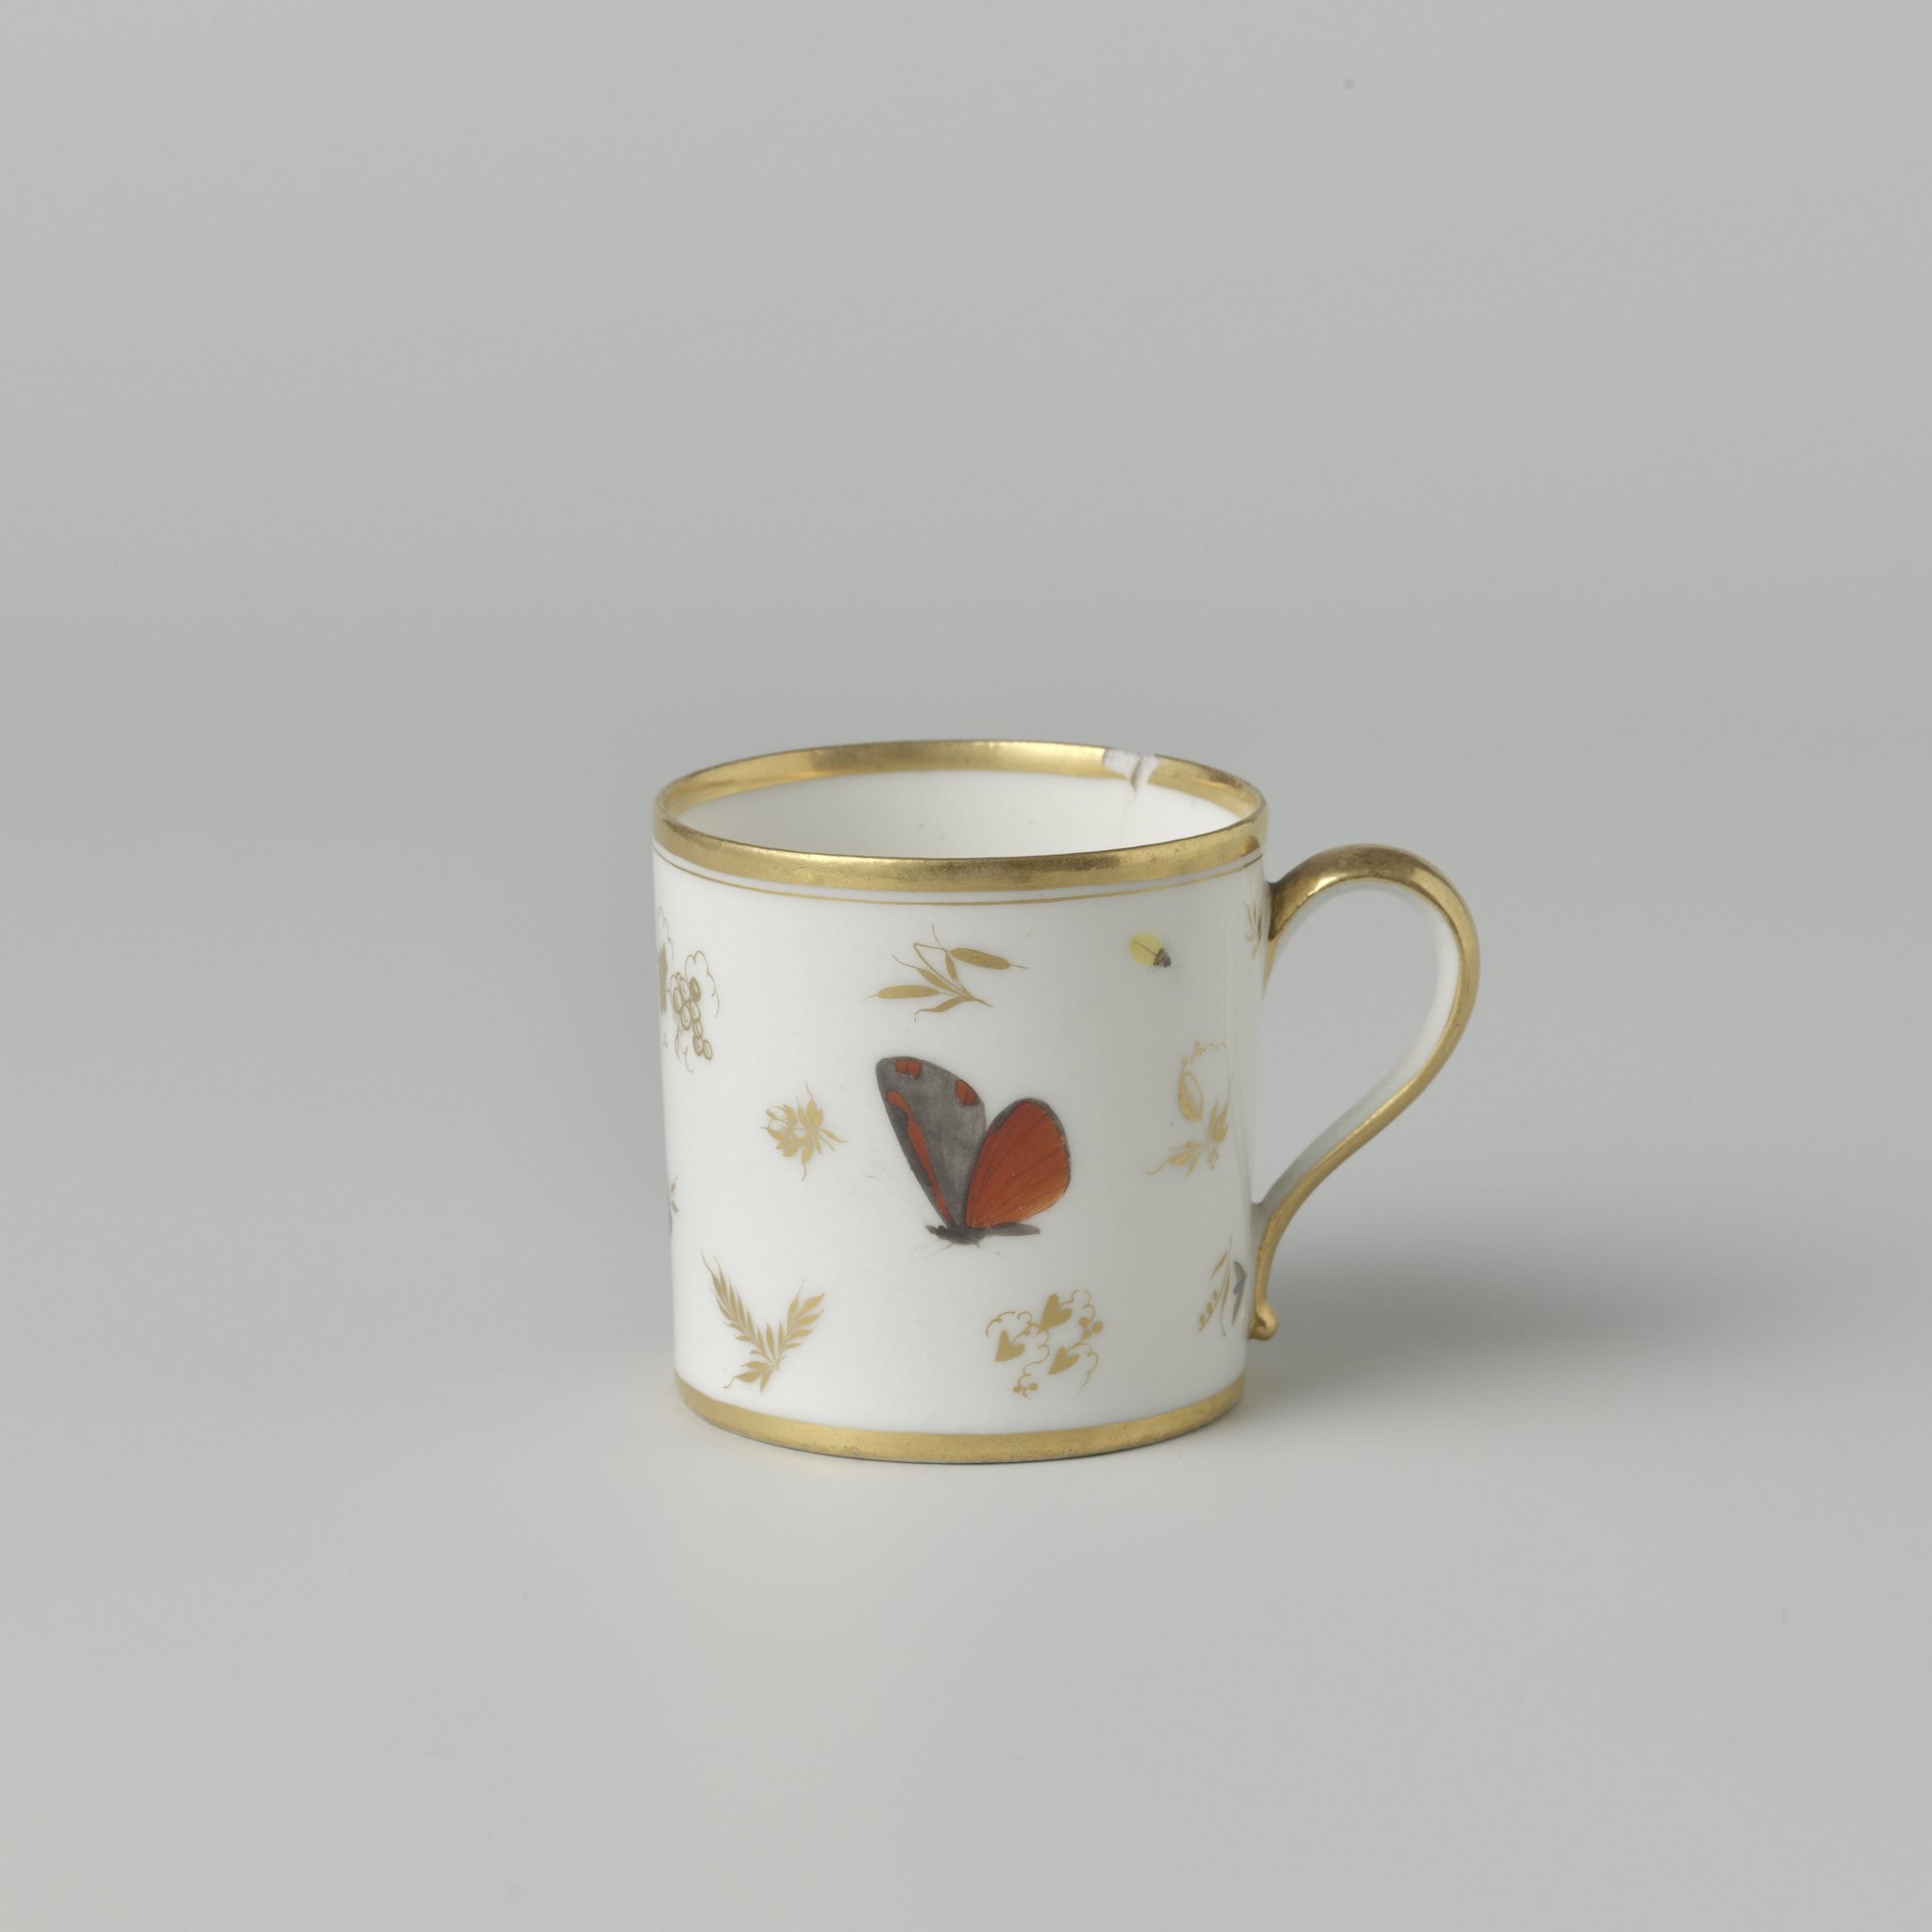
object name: service set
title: Cup with insects, flower sprays and grapevines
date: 1797-1798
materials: glaze, gold, paint, porcelain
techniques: firing, forming, gilding, turning, vitrification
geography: paris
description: Kop van porselein, deel van een theeservies, versierd met gouden randen, insecten in kleuren en gouden strooibloemen. Opmerking: sommige delen van het theeservies zijn gemerkt met de letters GB, Rue Thirou à Paris. Opmerking: verschillende koppen beschadigd; één met gebroken oor.